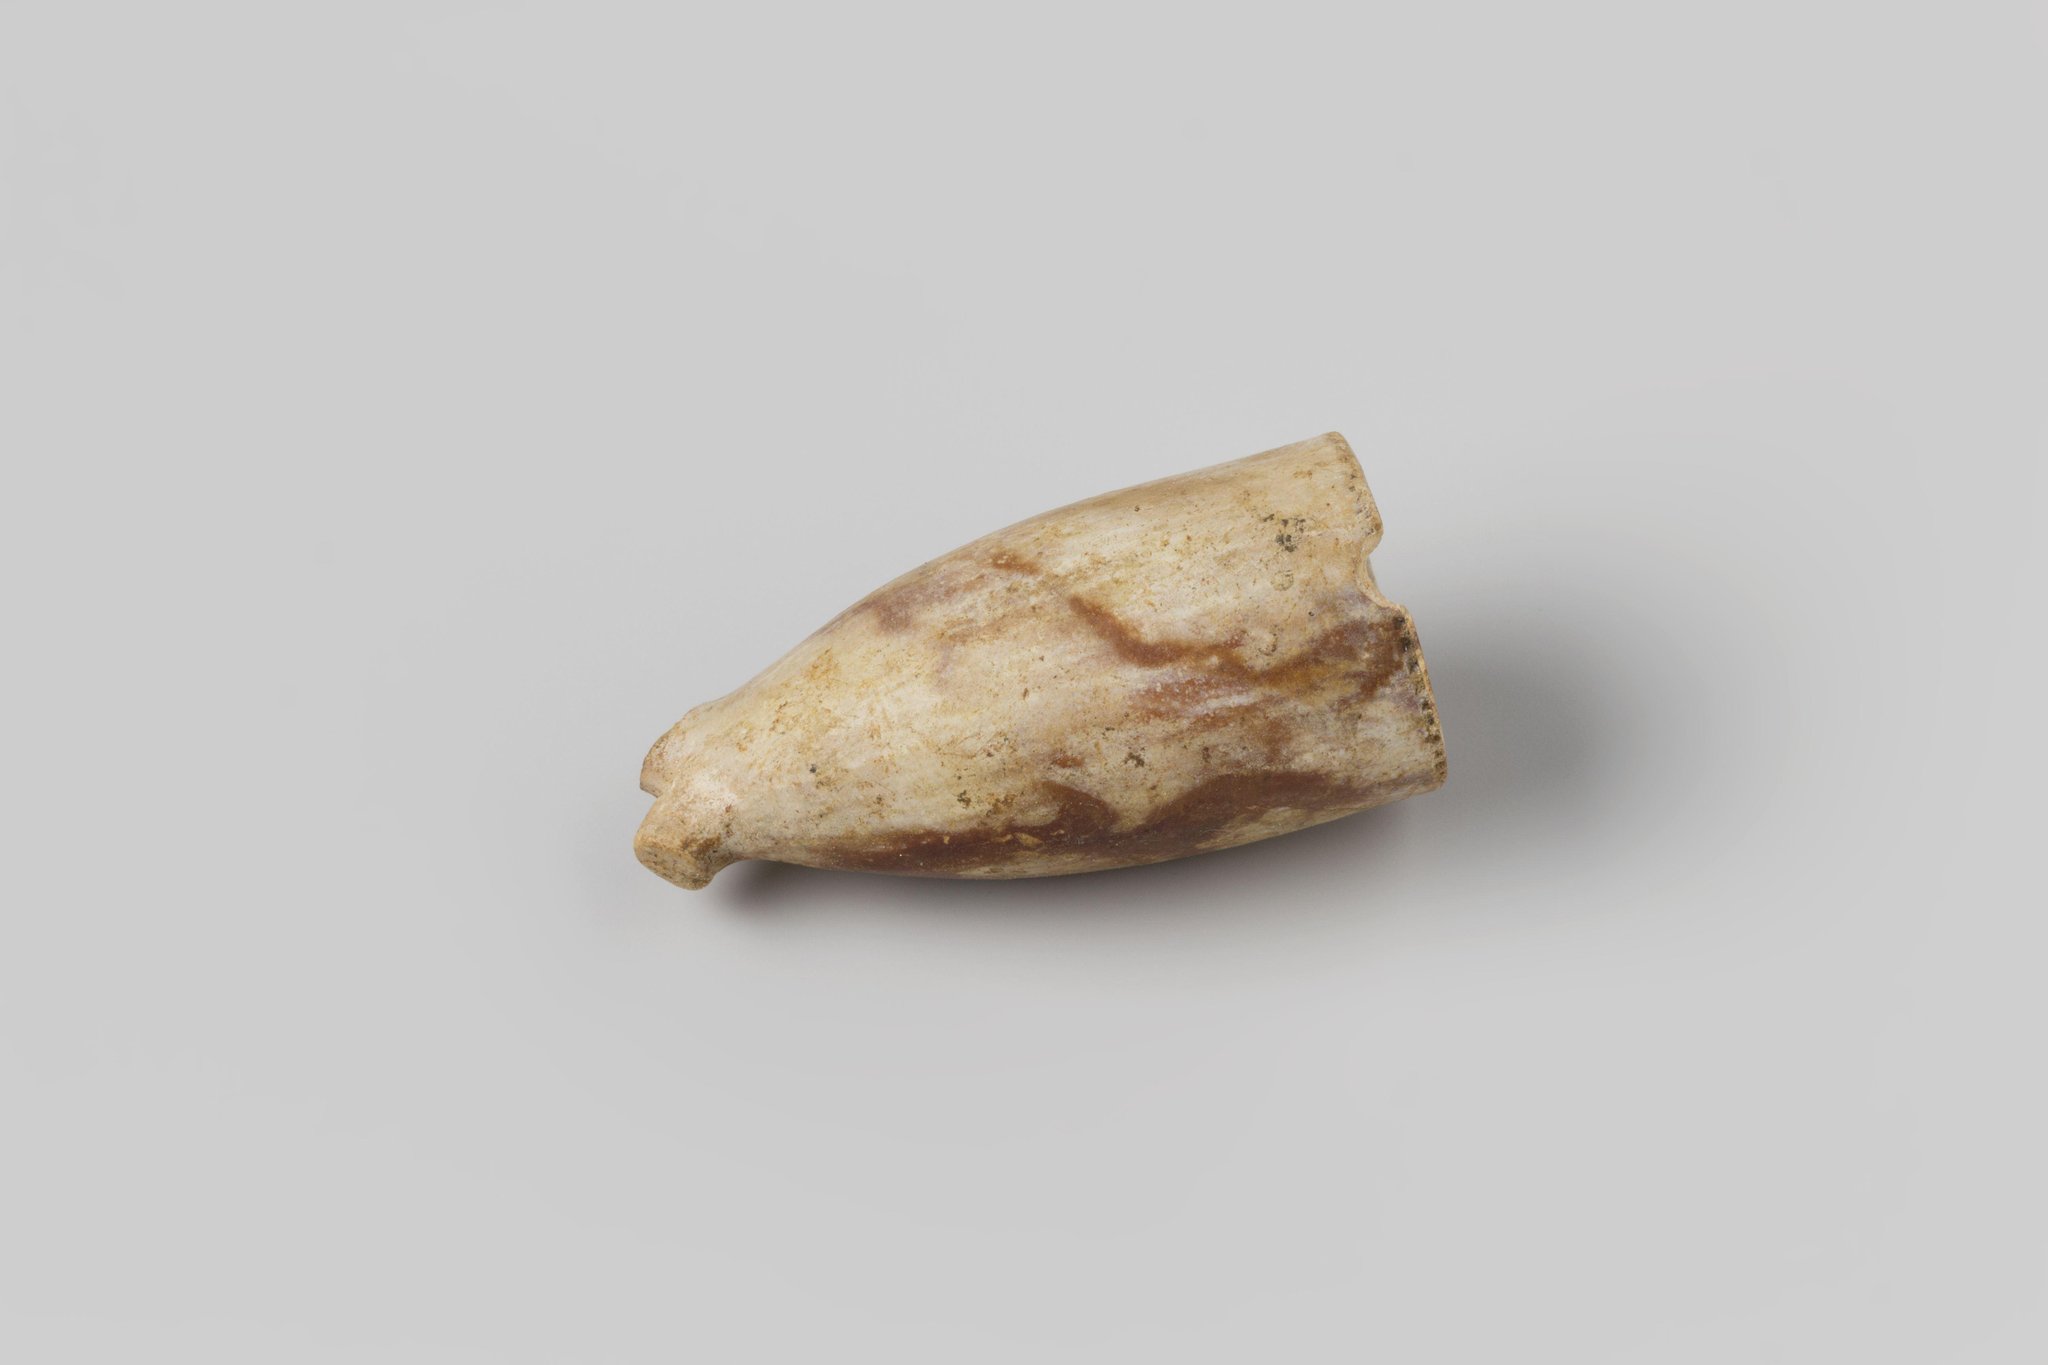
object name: pipe bowl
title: Pijpenkop uit het wrak van de Oost-Indiëvaarder Hollandia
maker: Anonymous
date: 1700-1743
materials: clay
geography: netherlands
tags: verenigde oostindische compagnie, hollandia (schip), annet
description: Pipe, bowl, heelmark: crowned 58; no hsm.